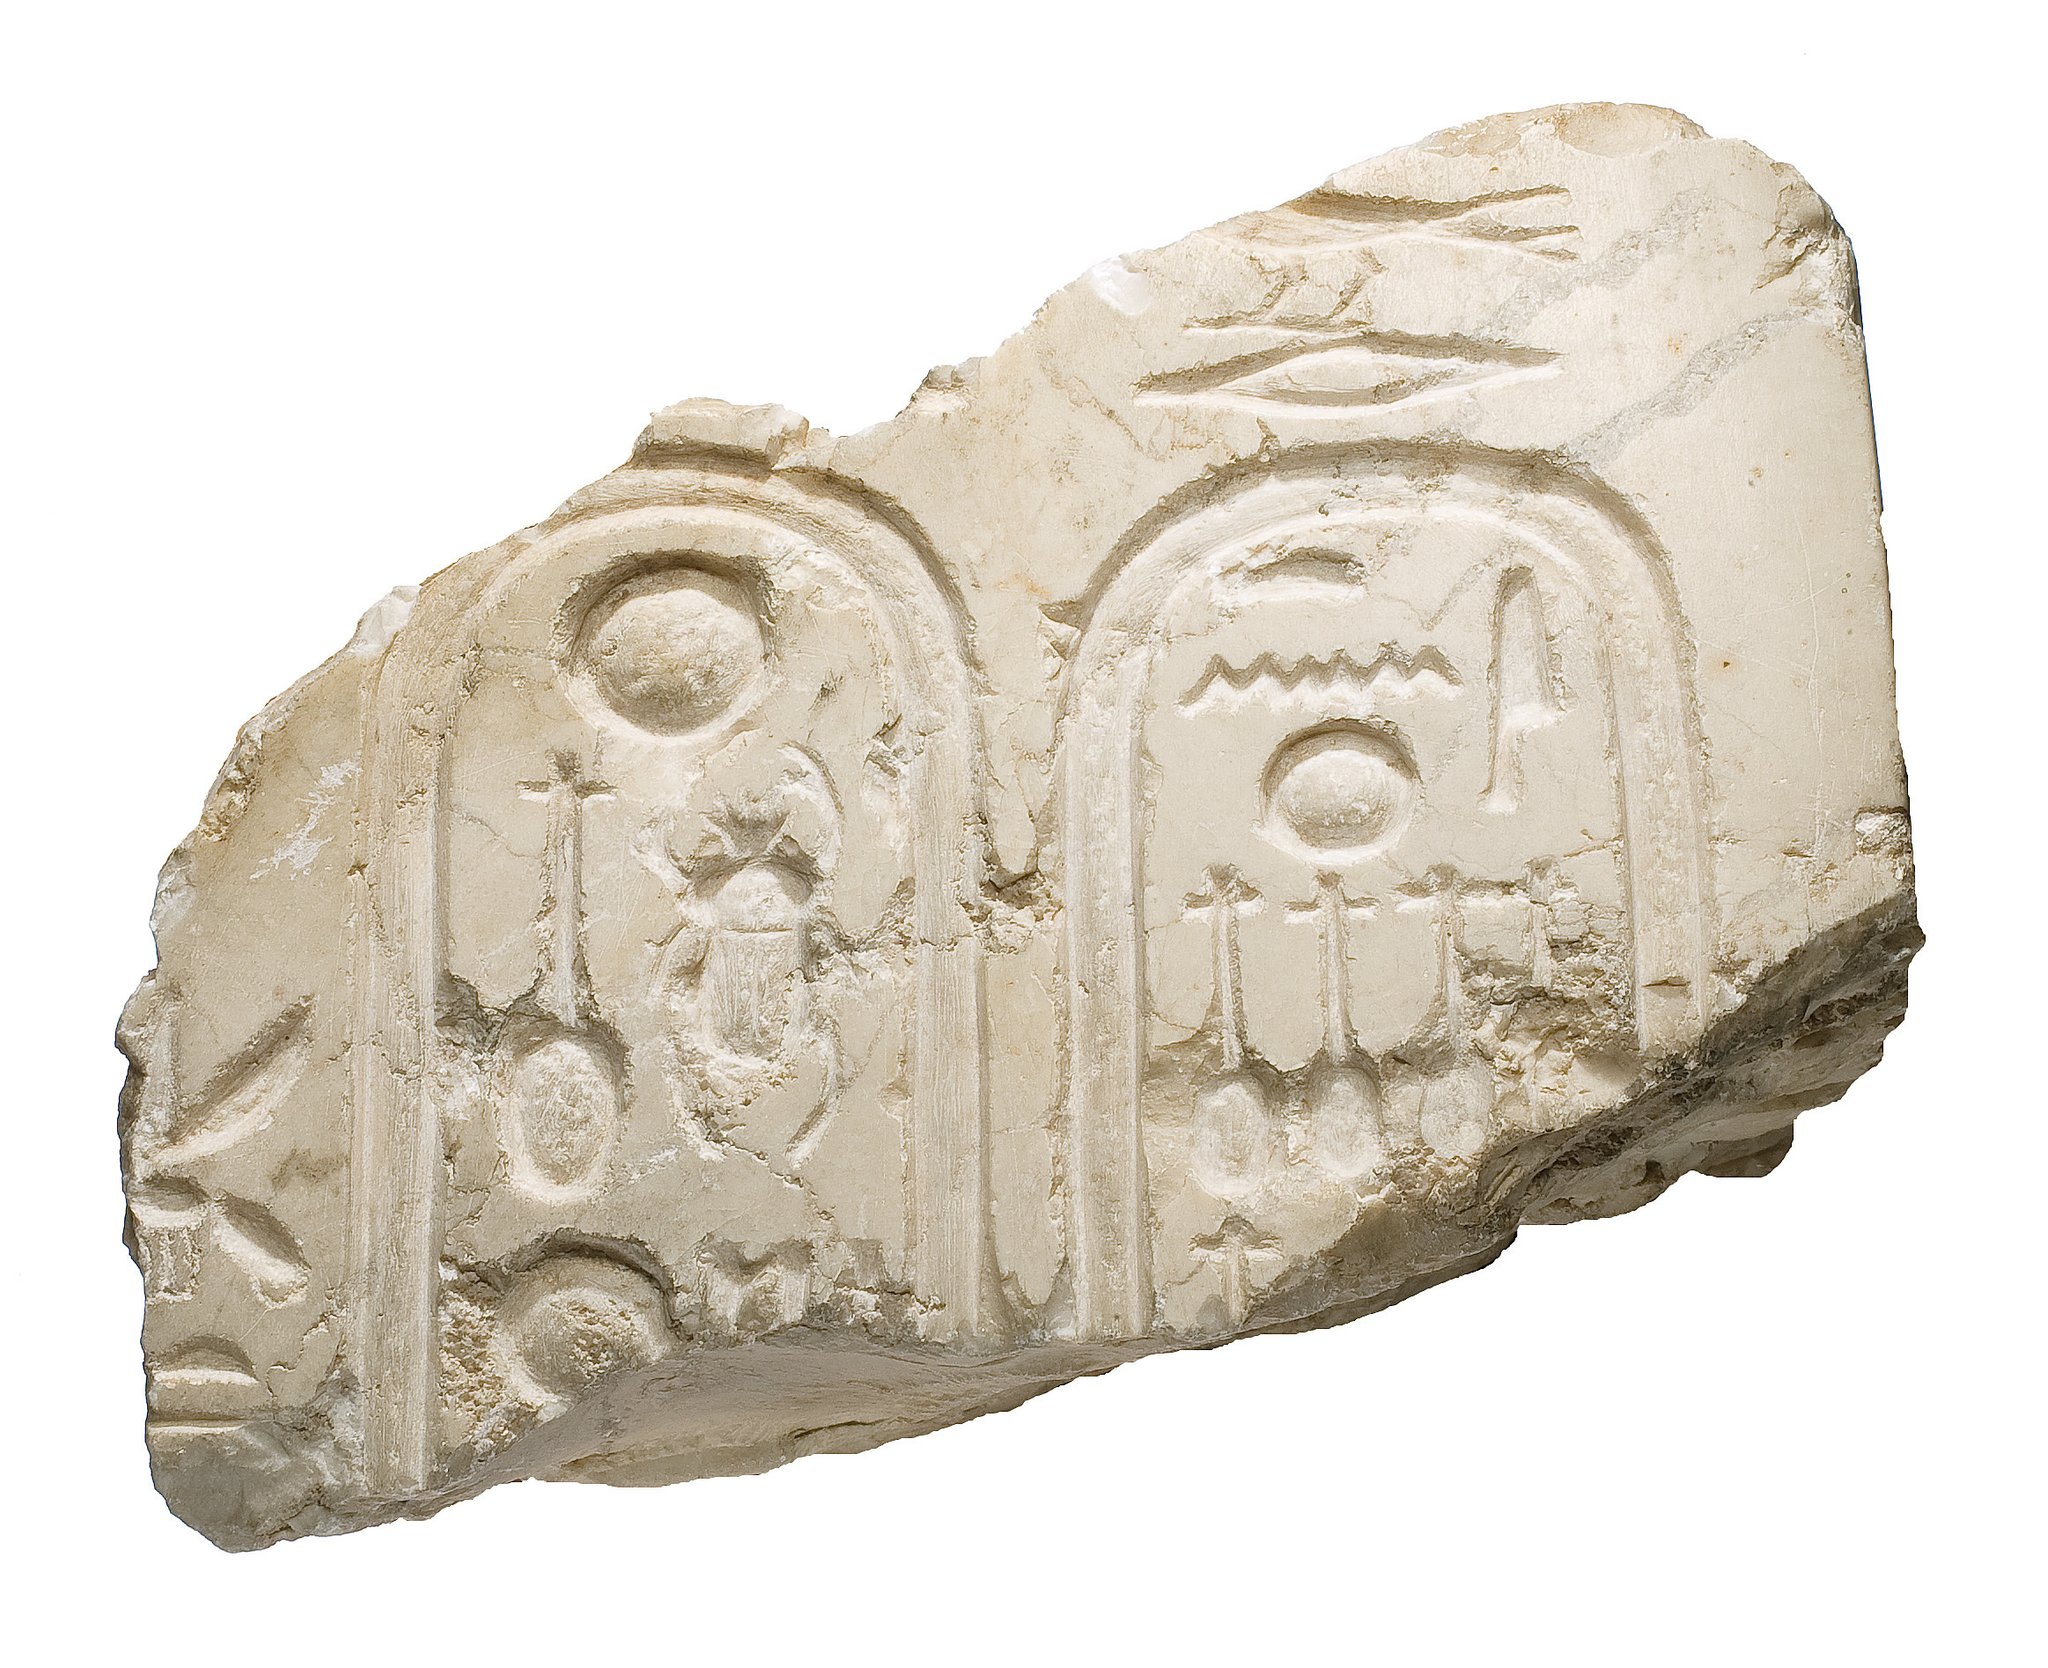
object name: akhenaten, nefertiti, aten cartouch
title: Inscribed fragment of a support pillar, Akhenaten, Nefetiti, Aten cartouches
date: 1353-1336 BCE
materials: limestone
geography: egypt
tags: hieroglyphs